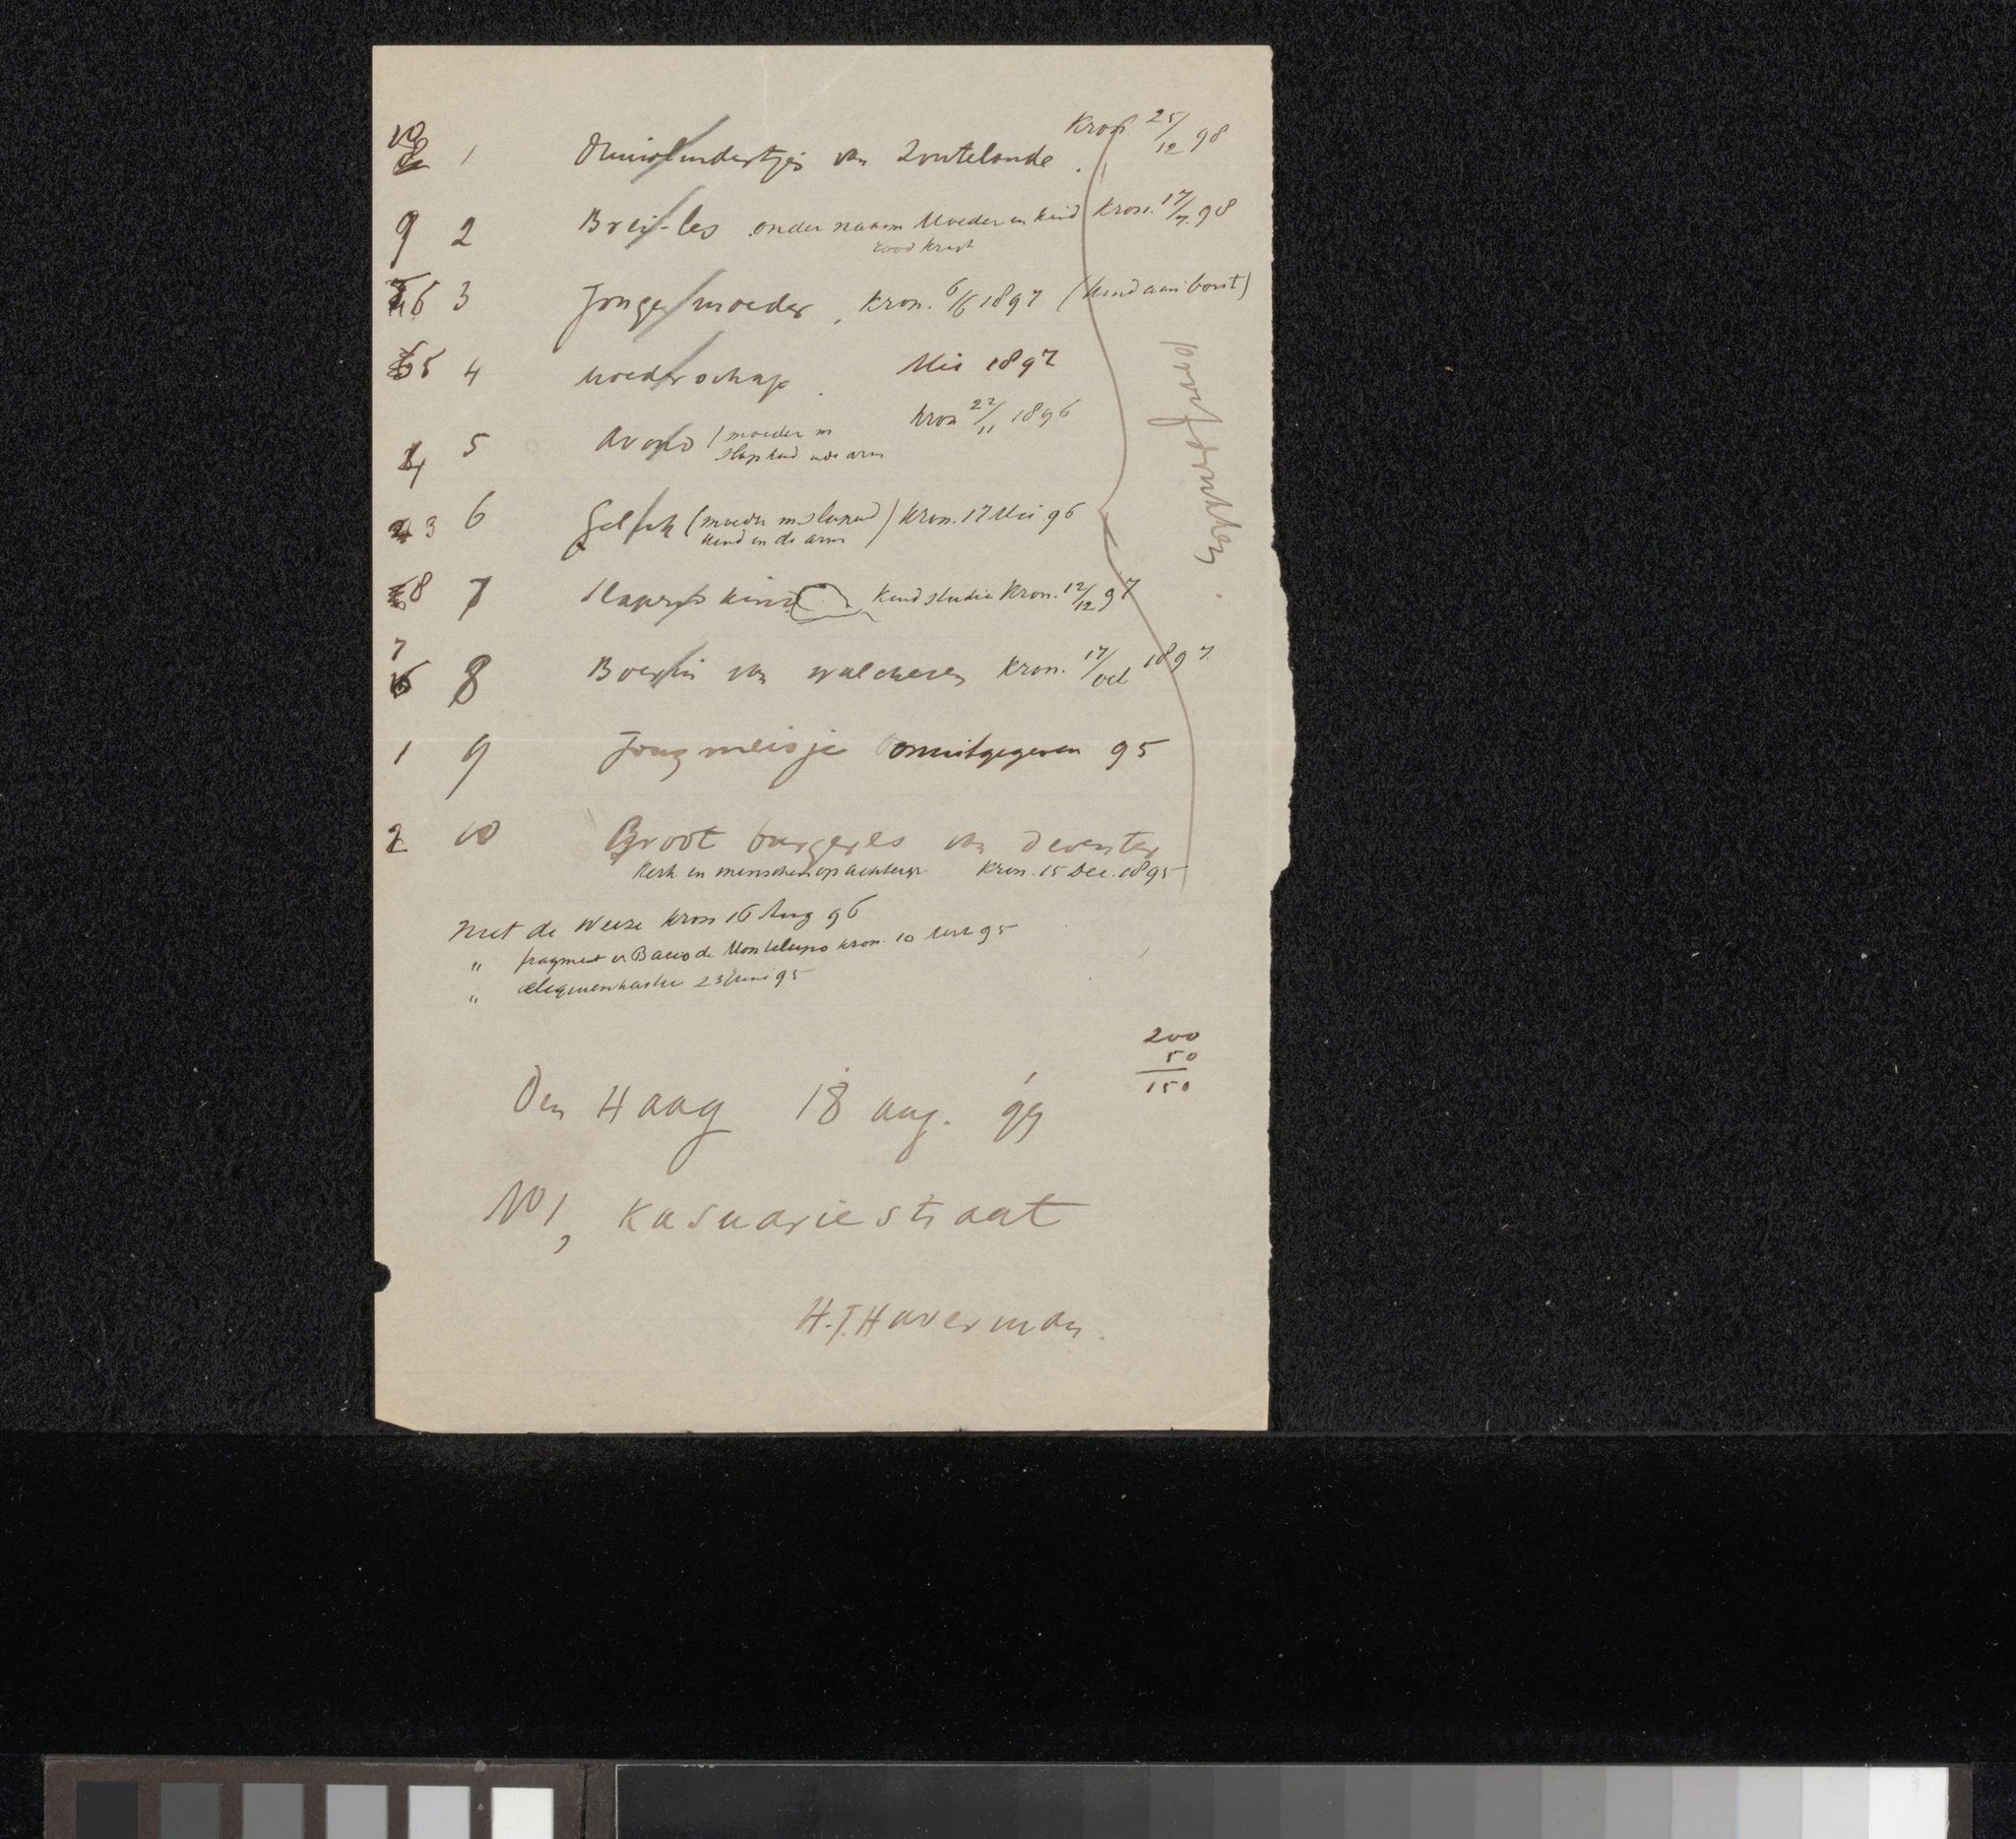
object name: letter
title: Brief aan Pieter Haverkorn van Rijsewijk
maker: hendrik johannes haverman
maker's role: draughtsman, print maker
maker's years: 1857-1928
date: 1899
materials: ink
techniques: pen, writing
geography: the hague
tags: pieter haverkorn van rijsewijk, the graphic arts